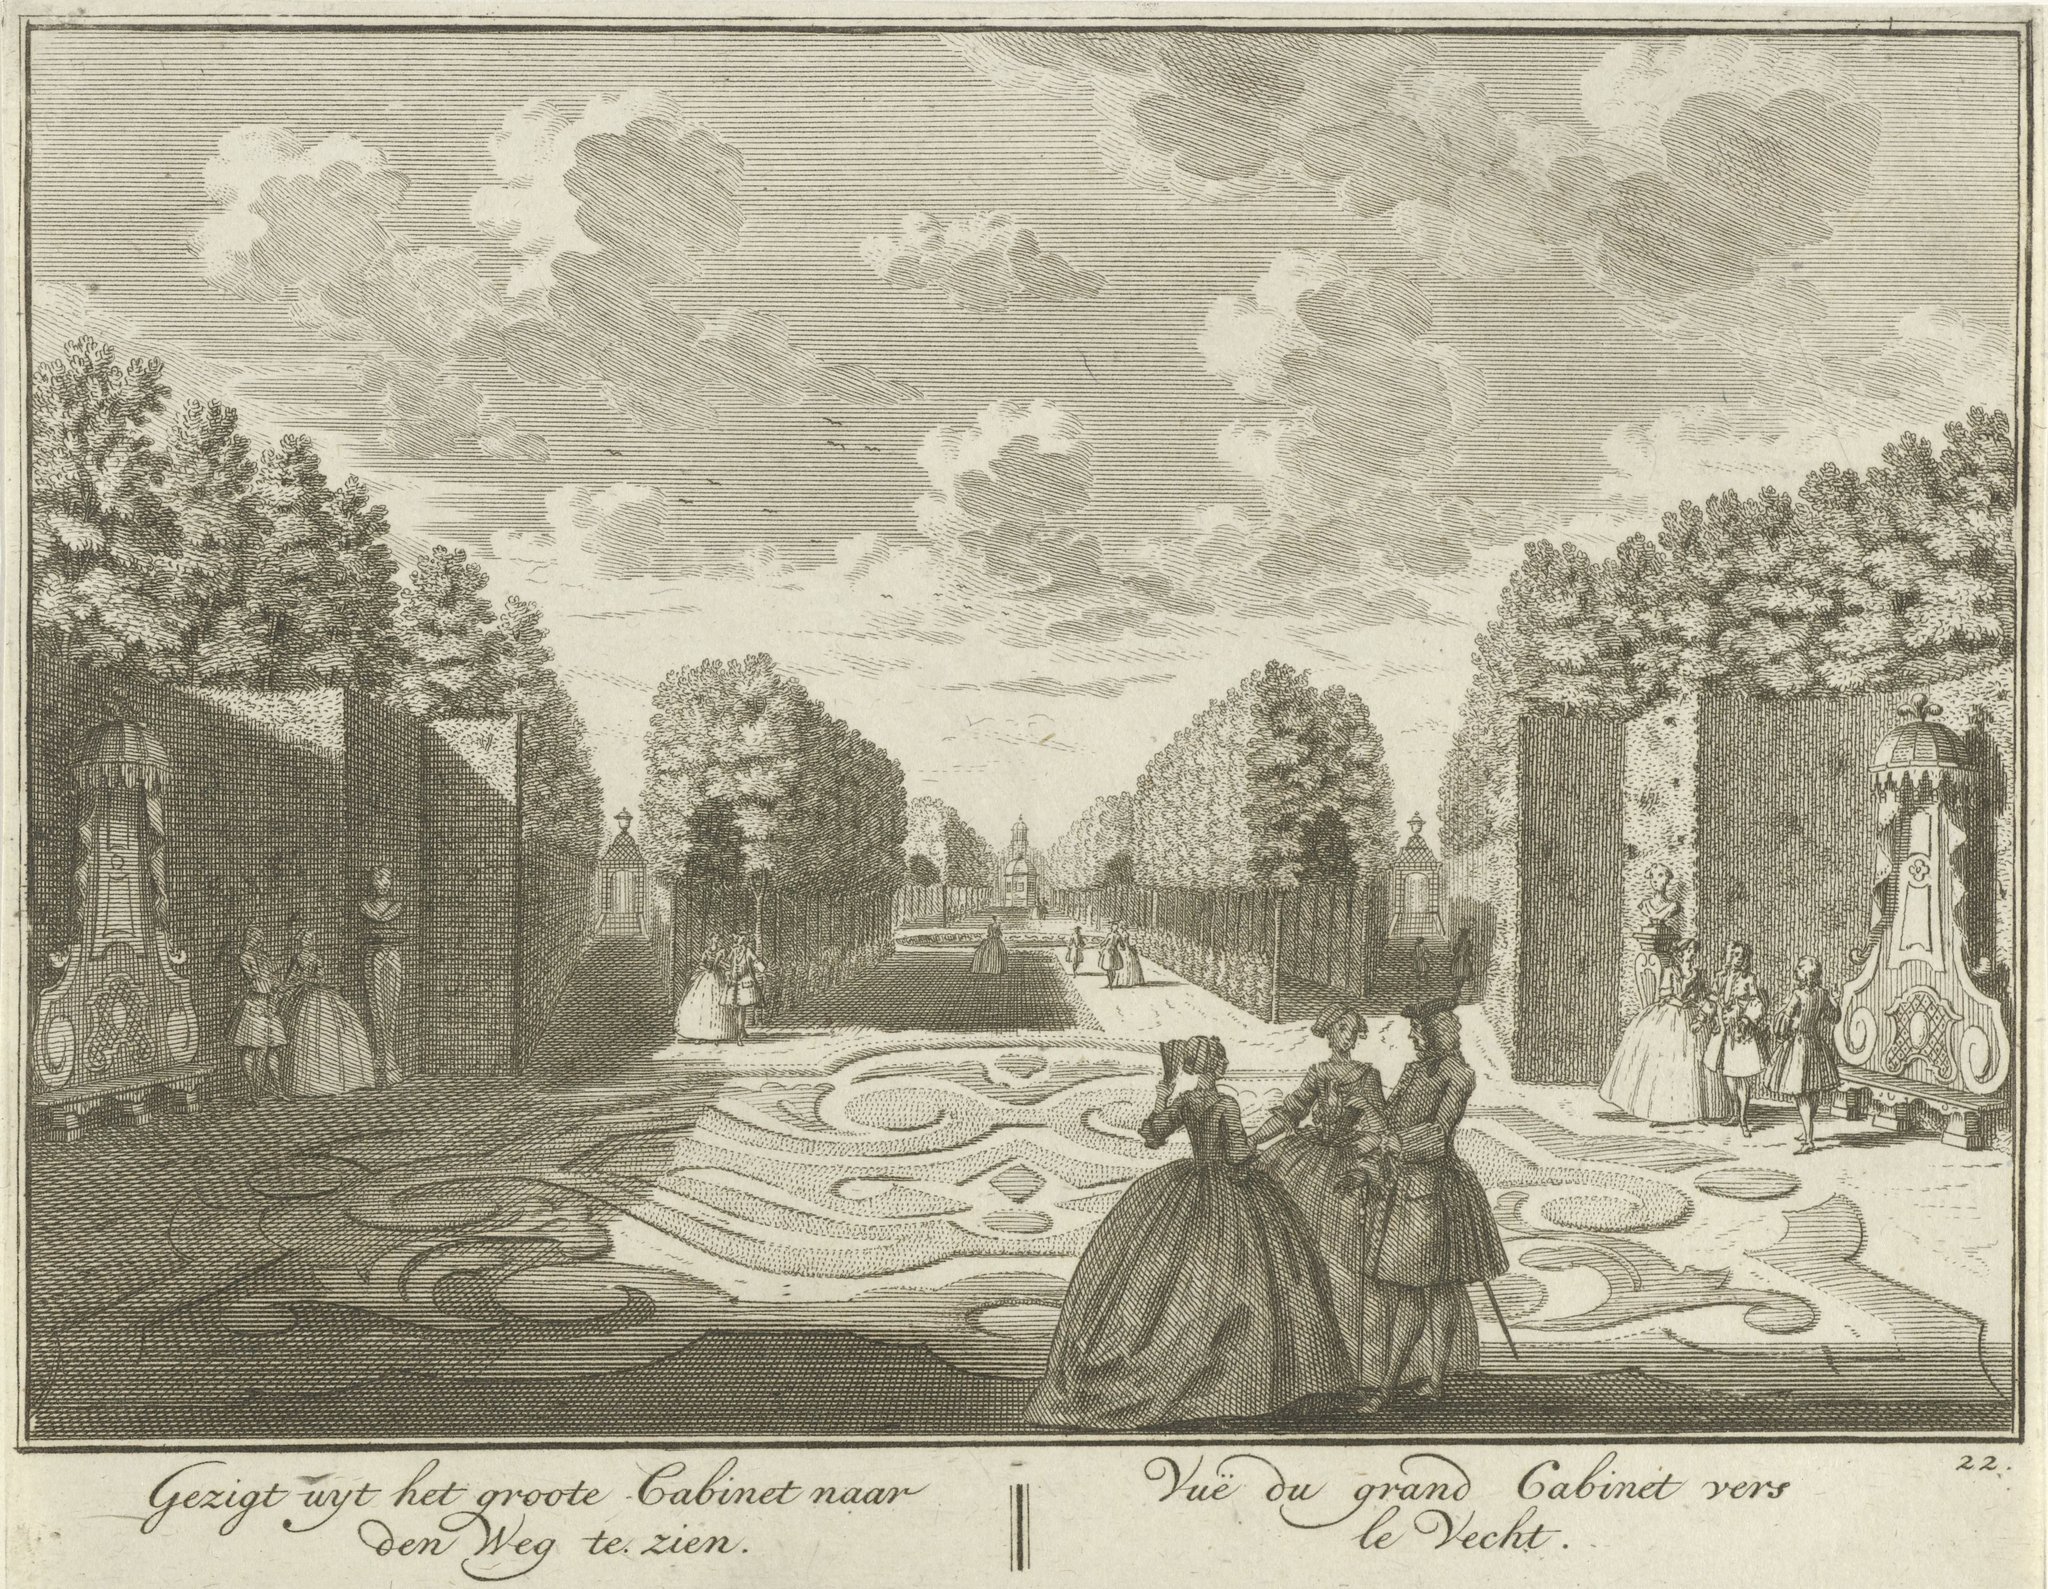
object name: print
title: Gezigt uyt het groote Cabinet naar den Weg te zien / Vue du grand Cabinet vers le Vecht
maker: hendrik de leth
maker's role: draughtsman, print maker, publisher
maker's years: 1703-1766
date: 1740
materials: paper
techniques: etching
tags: french or architectonic garden; formal garden, country-house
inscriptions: collector's mark: Lugt 2228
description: Gezicht vanuit het kabinet op de Franse tuin van Huis ter Meer. Verspreid door de tuin staan groepjes figuren te converseren. De prent maakt deel uit van een serie met 26 gezichten op Huis ter Meer en het bijbehorende landgoed te Maarssen.